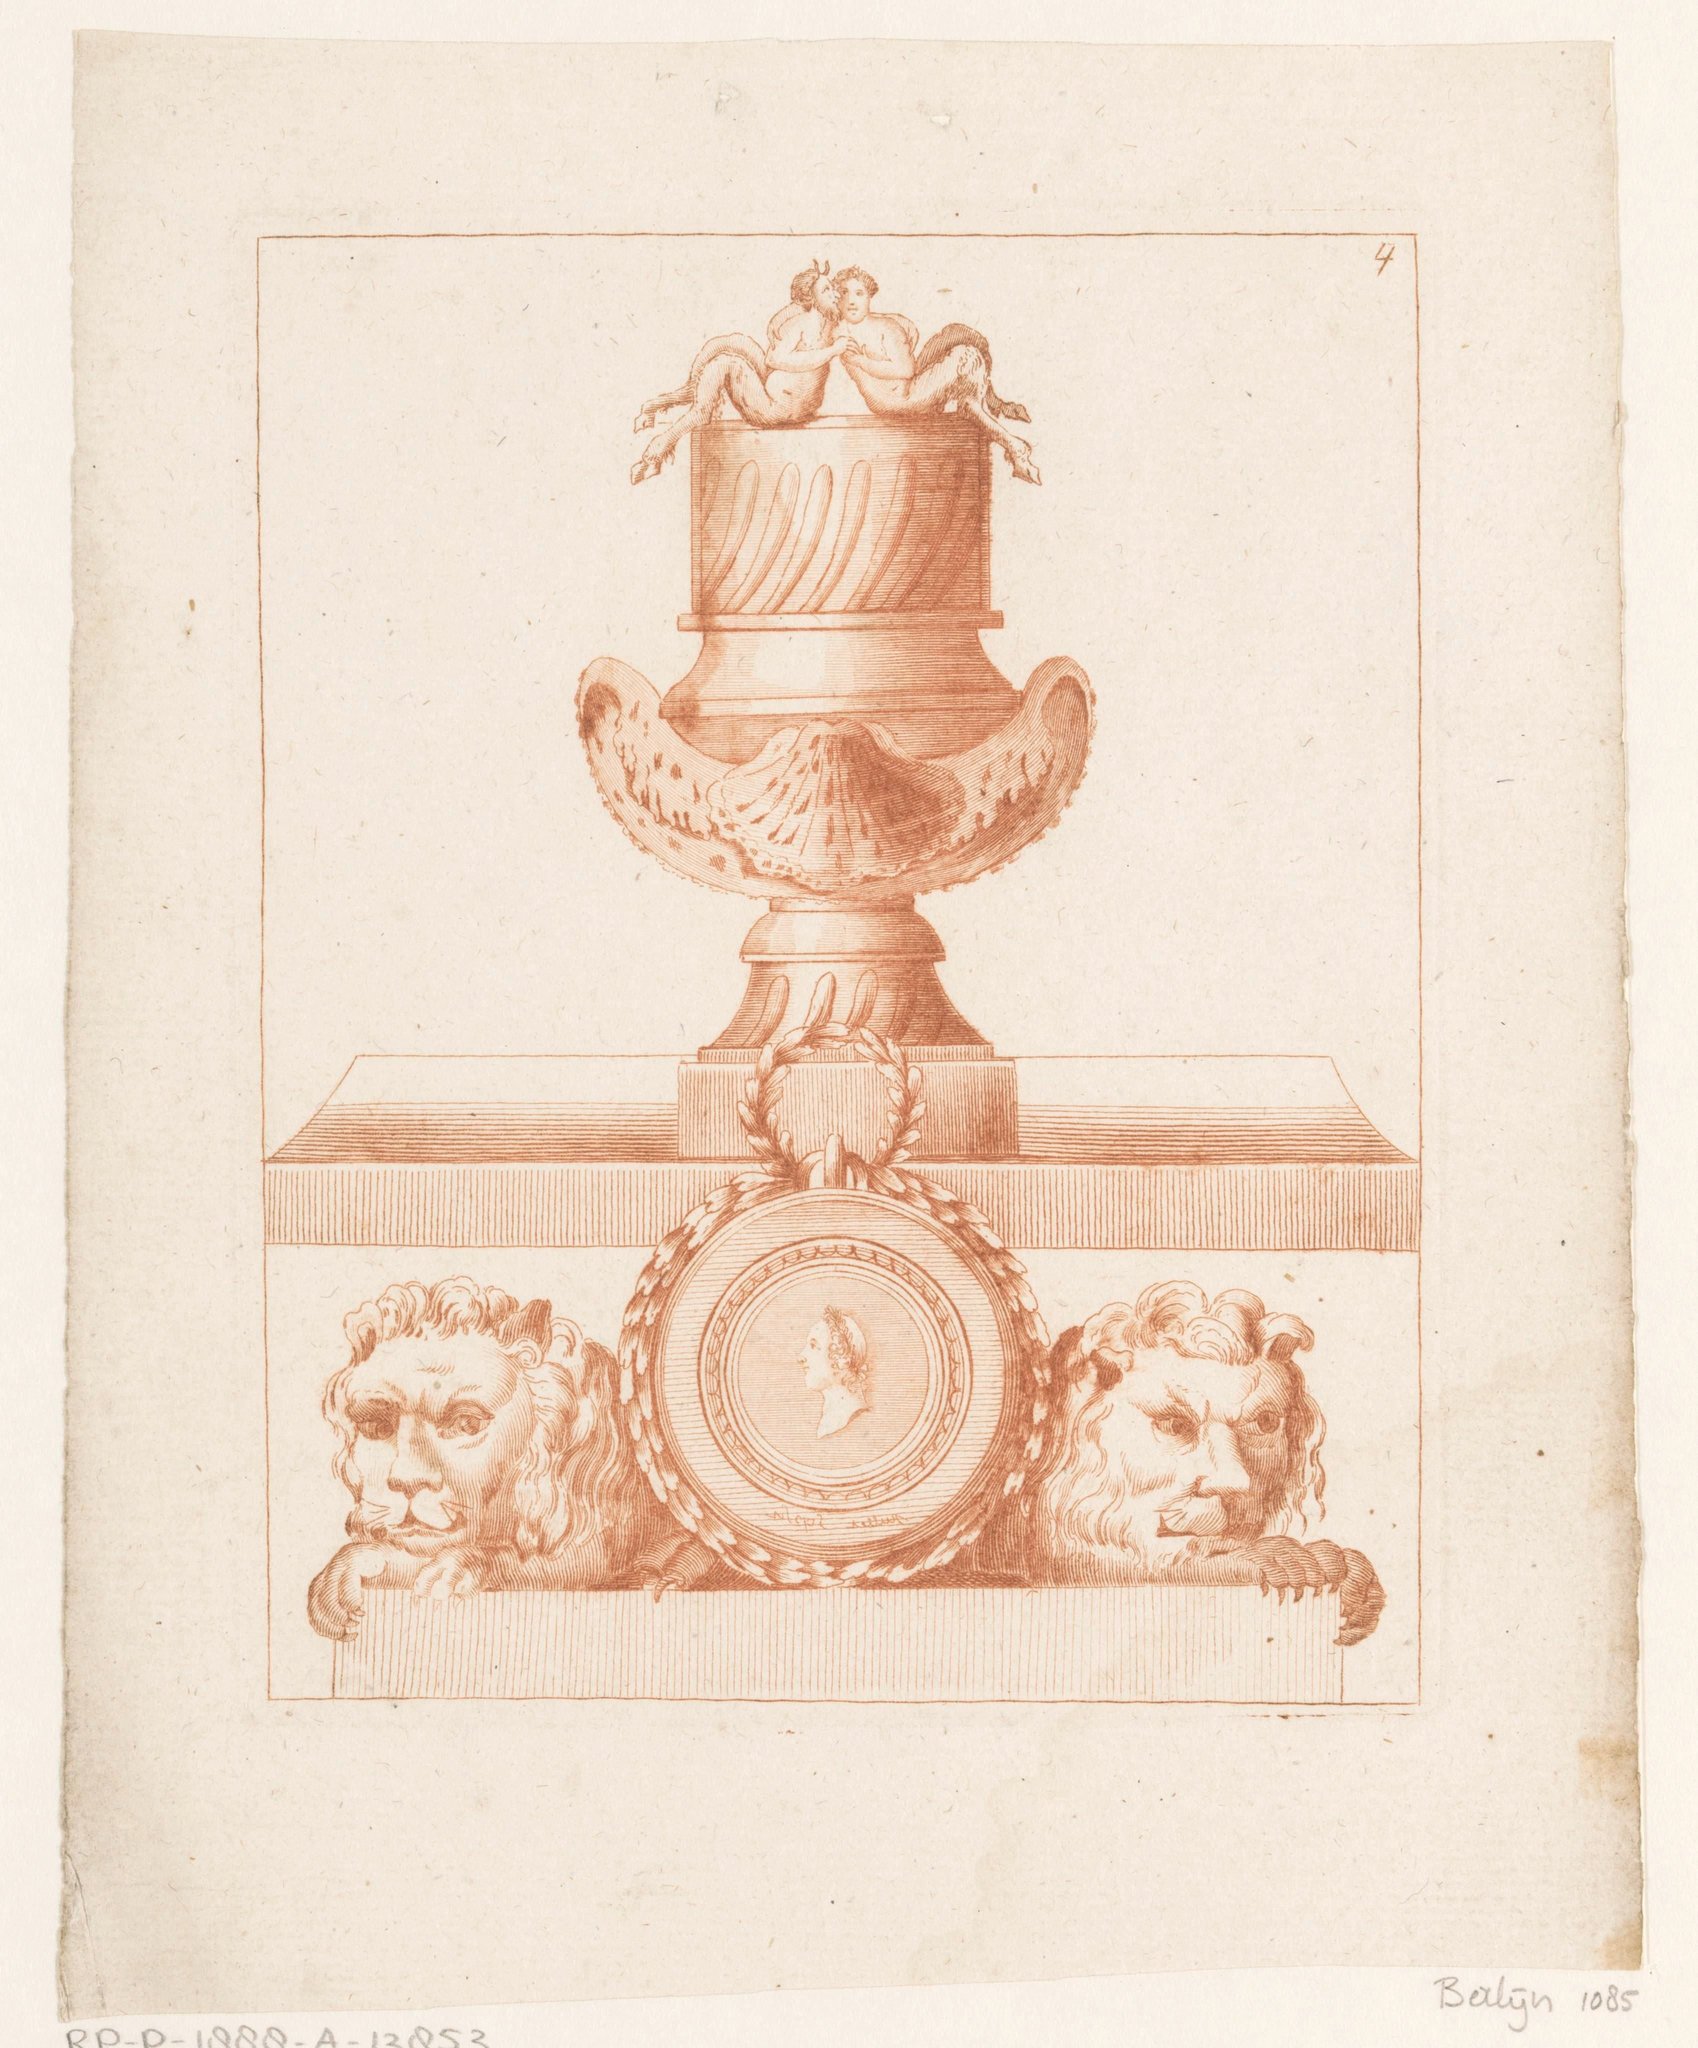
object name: ornament print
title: Vaas met saters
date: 1768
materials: paper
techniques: etching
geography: paris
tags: vase ~ ornament, satyr(s) (in general)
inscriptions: collector's mark: Lugt 2228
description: Een vaas met twee zittende saters en een schelpmotief. Daaronder een medaillon geflankeerd door twee leeuwen.